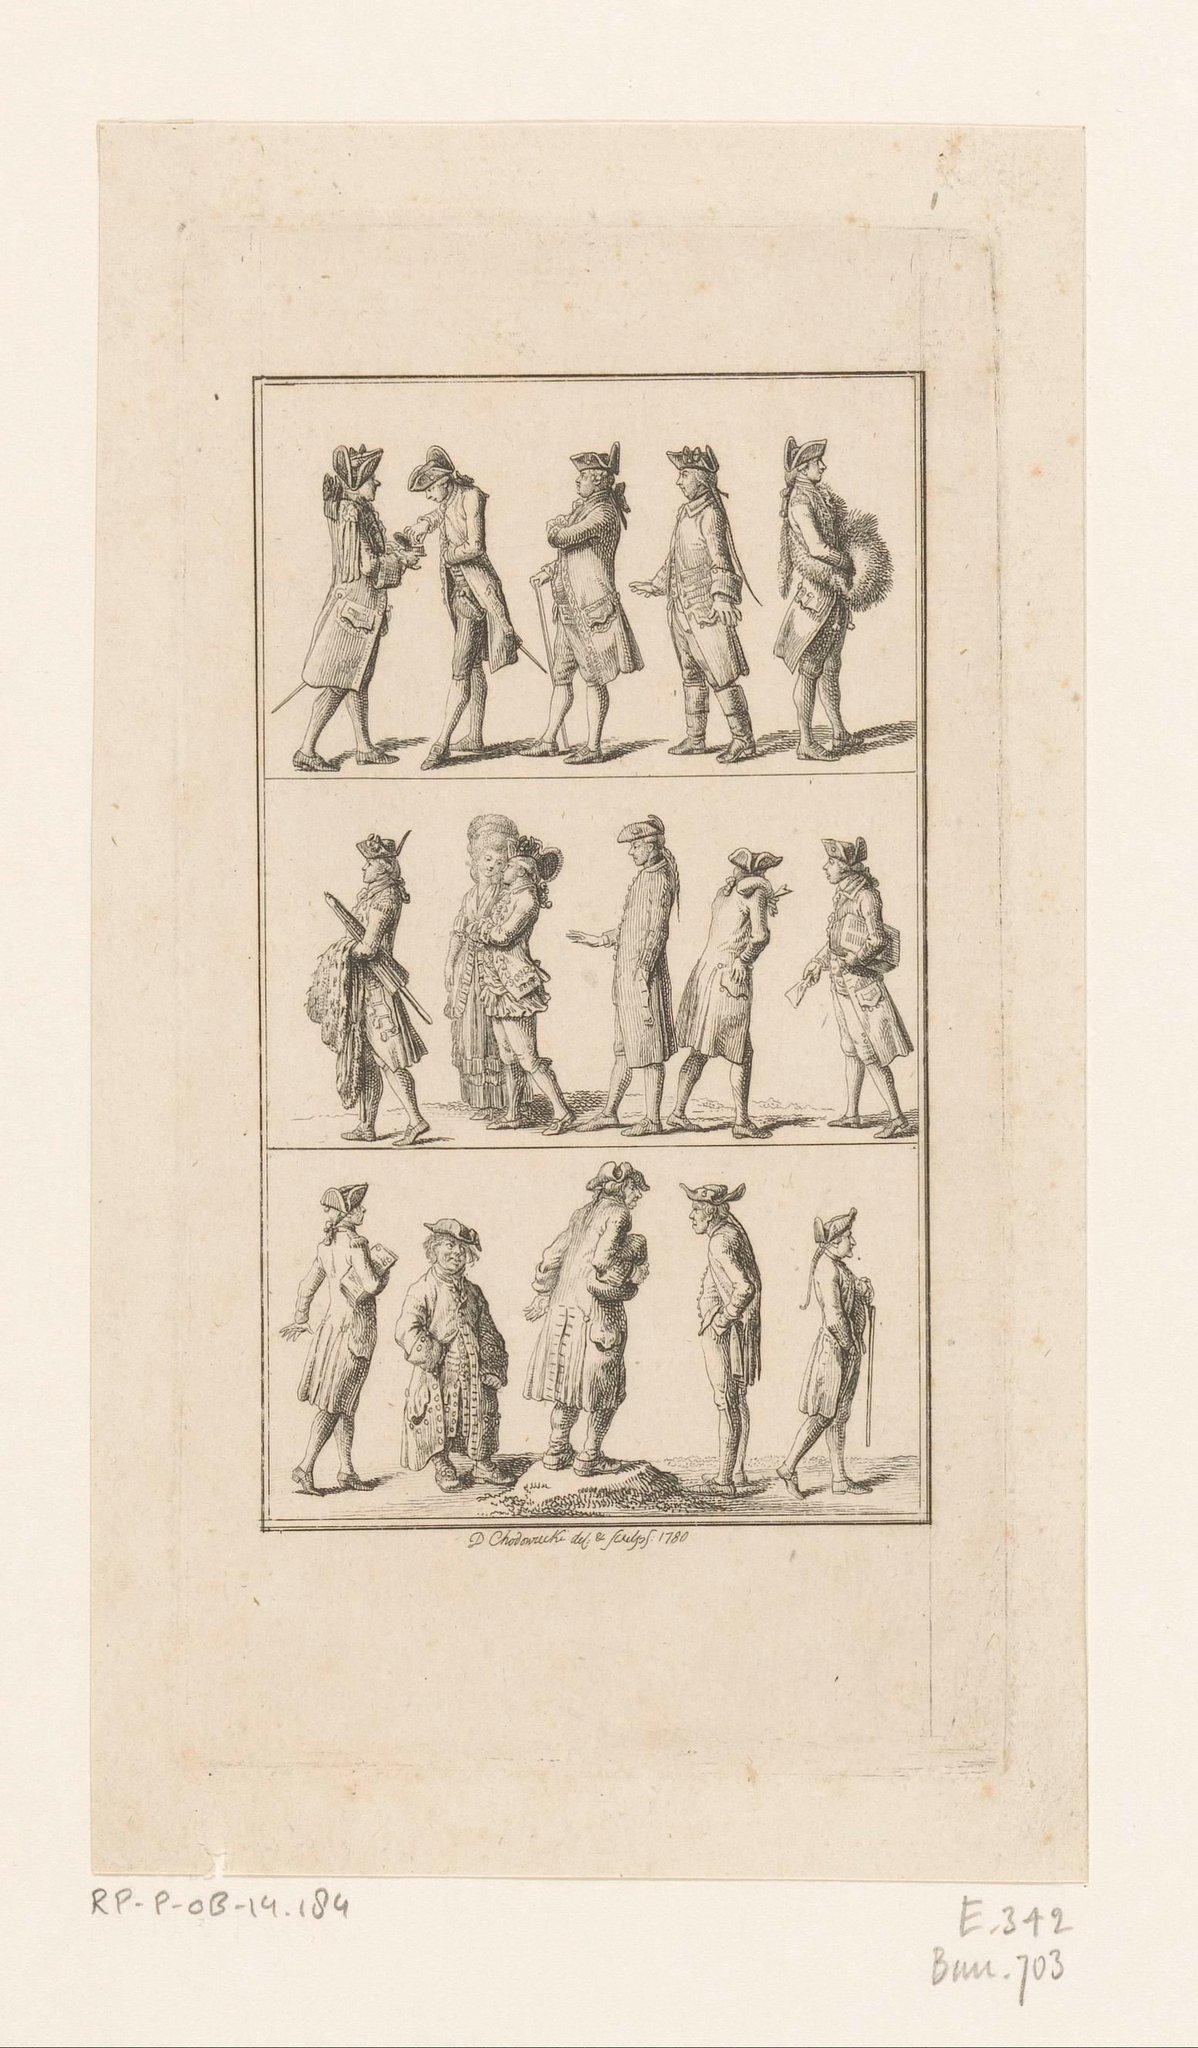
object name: print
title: Mannelijke bedienden en een vrouw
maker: daniel nikolaus chodowiecki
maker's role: draughtsman, print maker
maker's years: 1726-1801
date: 1780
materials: paper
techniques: etching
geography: berlin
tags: physicist, snuff, manservant, footman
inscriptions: collector's mark: Lugt 2228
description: Deze prent maakt deel uit van een serie van vier prenten die verschenen als voorbeeld van illustraties voor een nieuwe uitgave van Orbis Pictus door Georg Christoph Lichtenberg. Prent ook gebruikt in: Göttingisches Magazin der Wissenschaften und Litteratur. Göttingen: Johann Christian Dieterich, 1780, eerste jaargang, derde stuk.